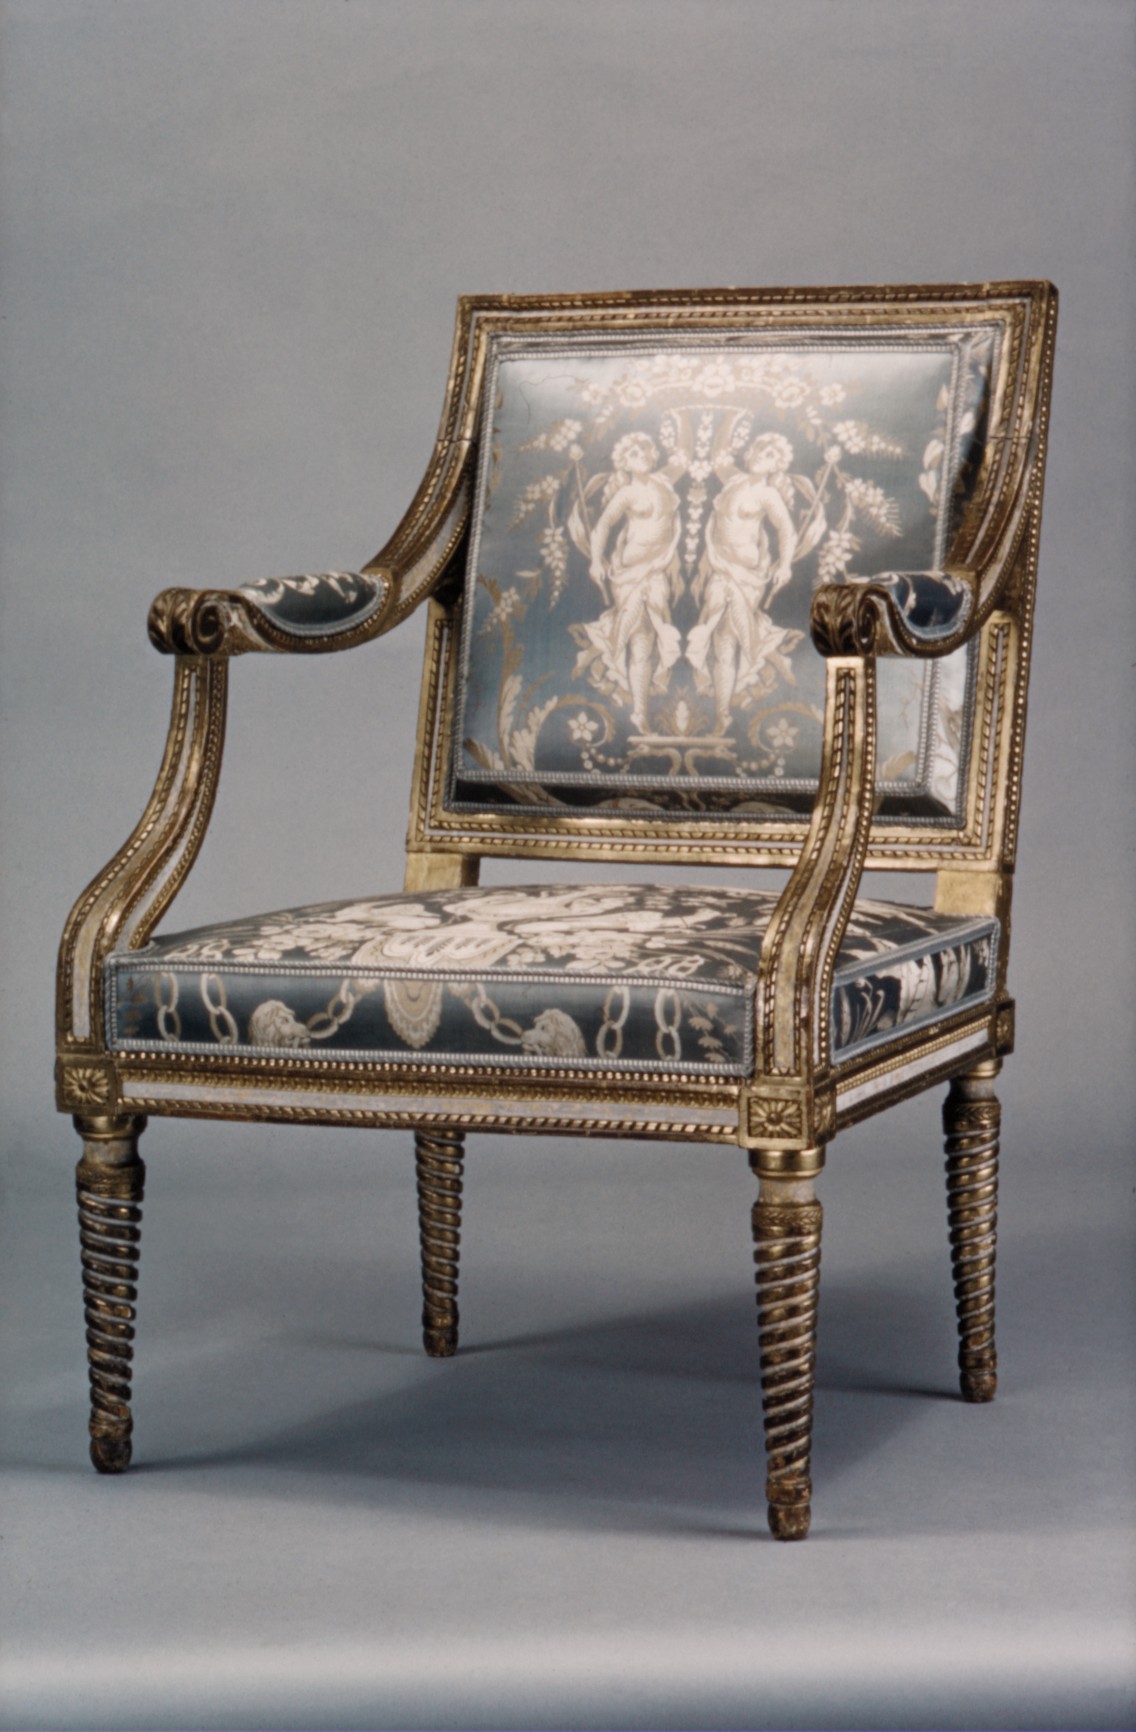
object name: armchair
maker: sulpice brizard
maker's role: maker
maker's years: 1735-1798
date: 1701-1800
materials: wood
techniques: carving, gilding, painting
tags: human figures